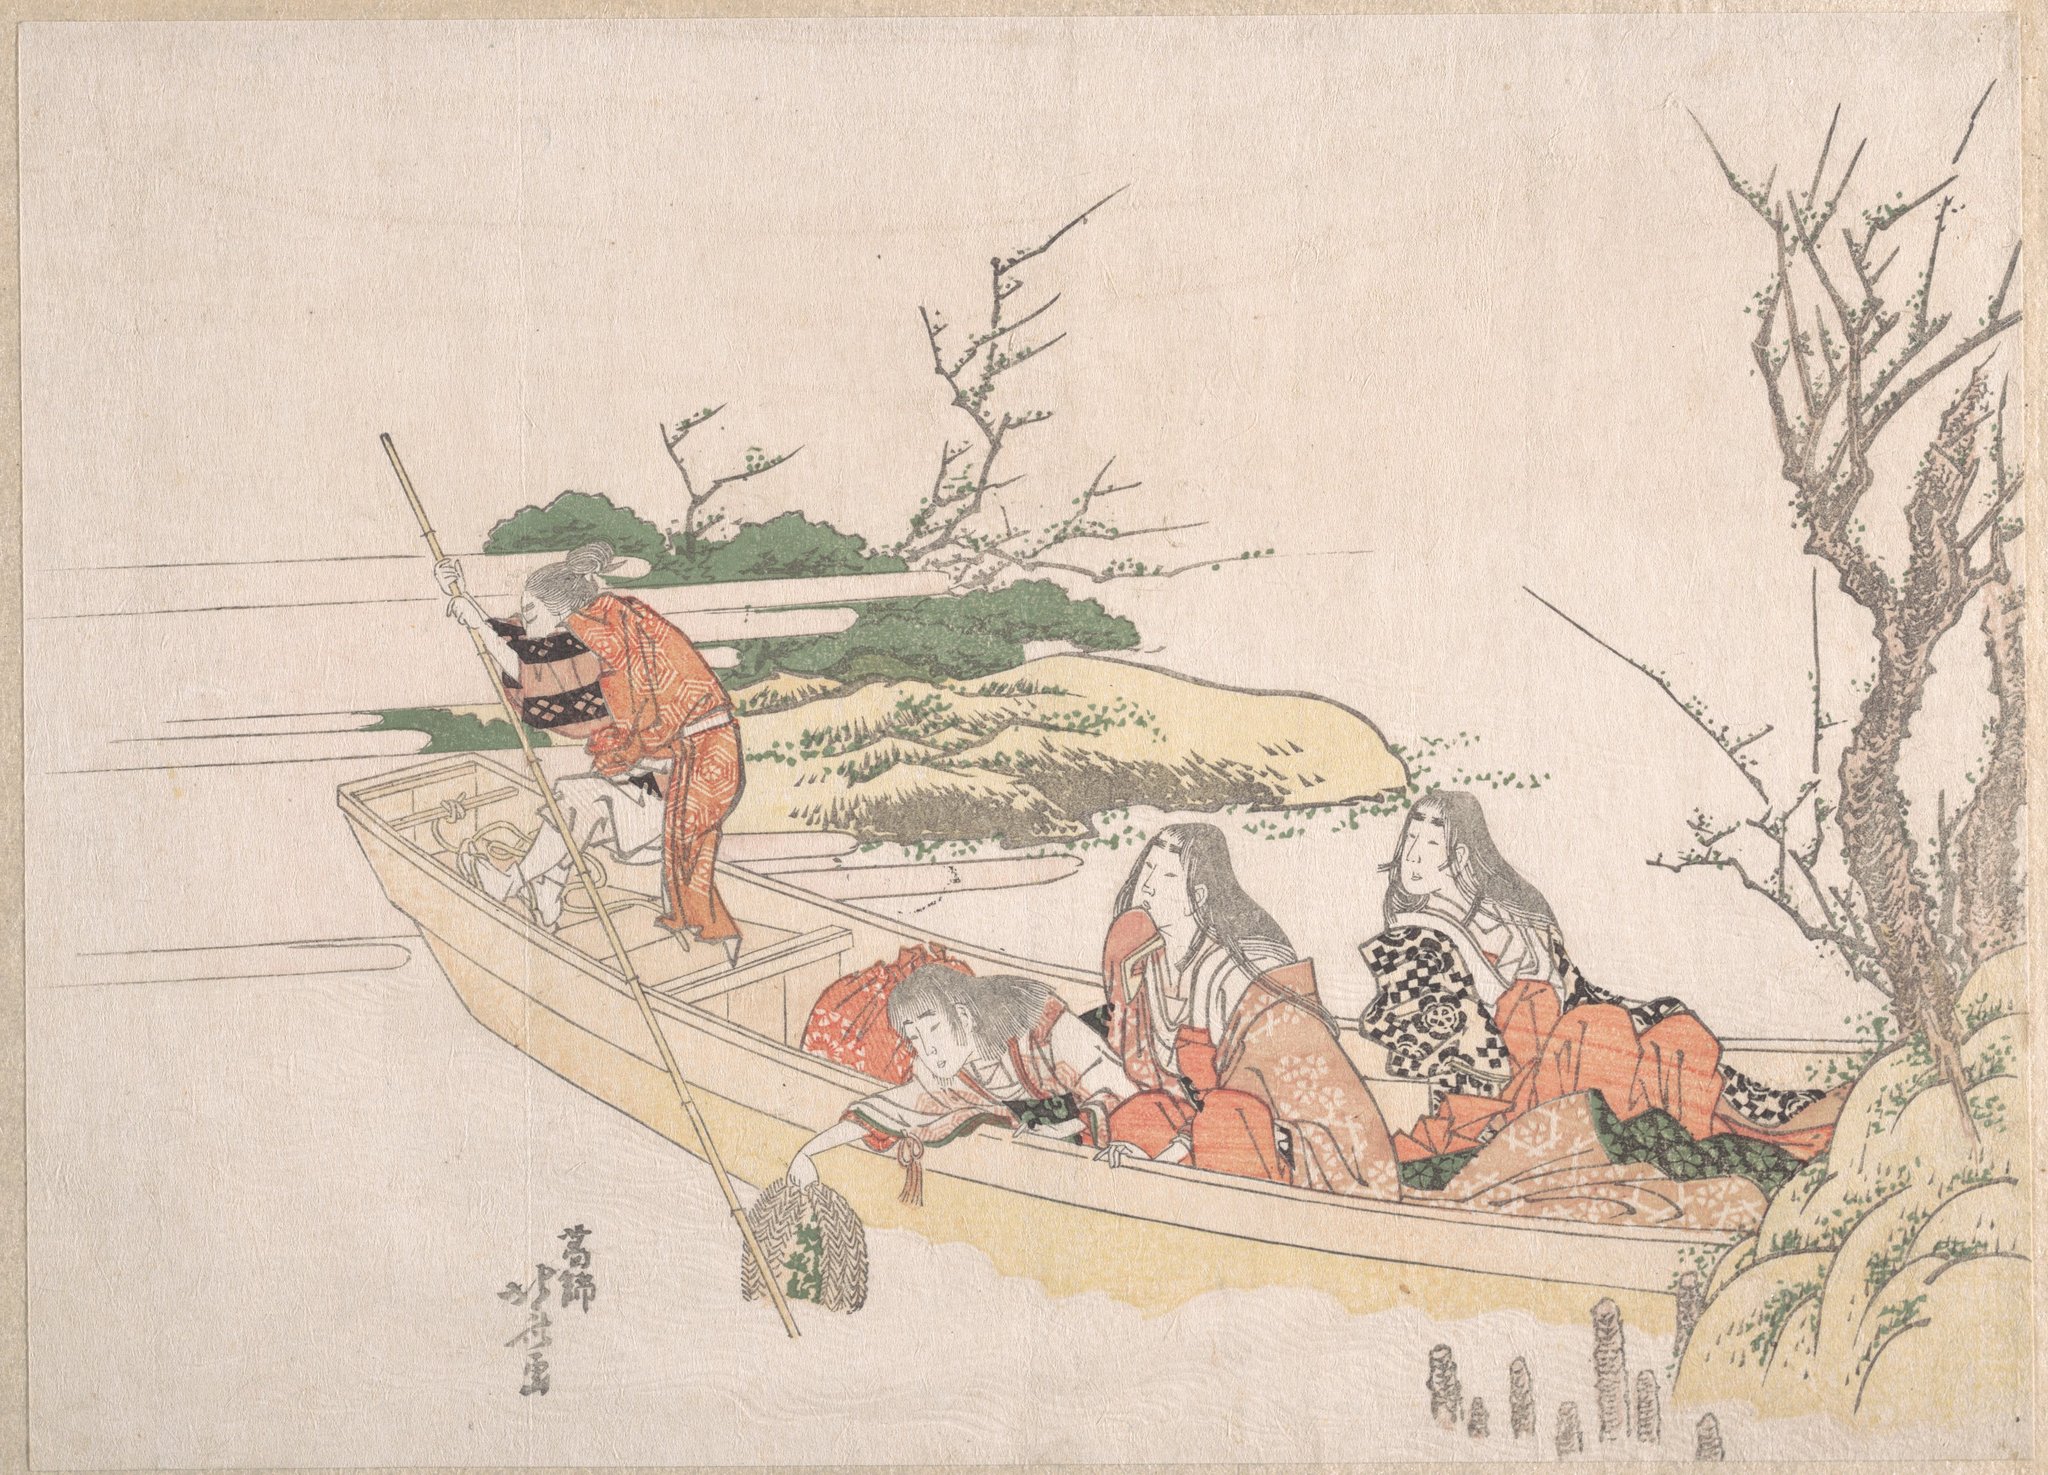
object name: print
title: Gathering Sea-Weed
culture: japanese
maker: katsushika hokusai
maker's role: artist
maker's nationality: japanese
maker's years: 1760-1849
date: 1760-1849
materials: ink, paper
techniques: surimono, woodblock print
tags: women,trees,boats